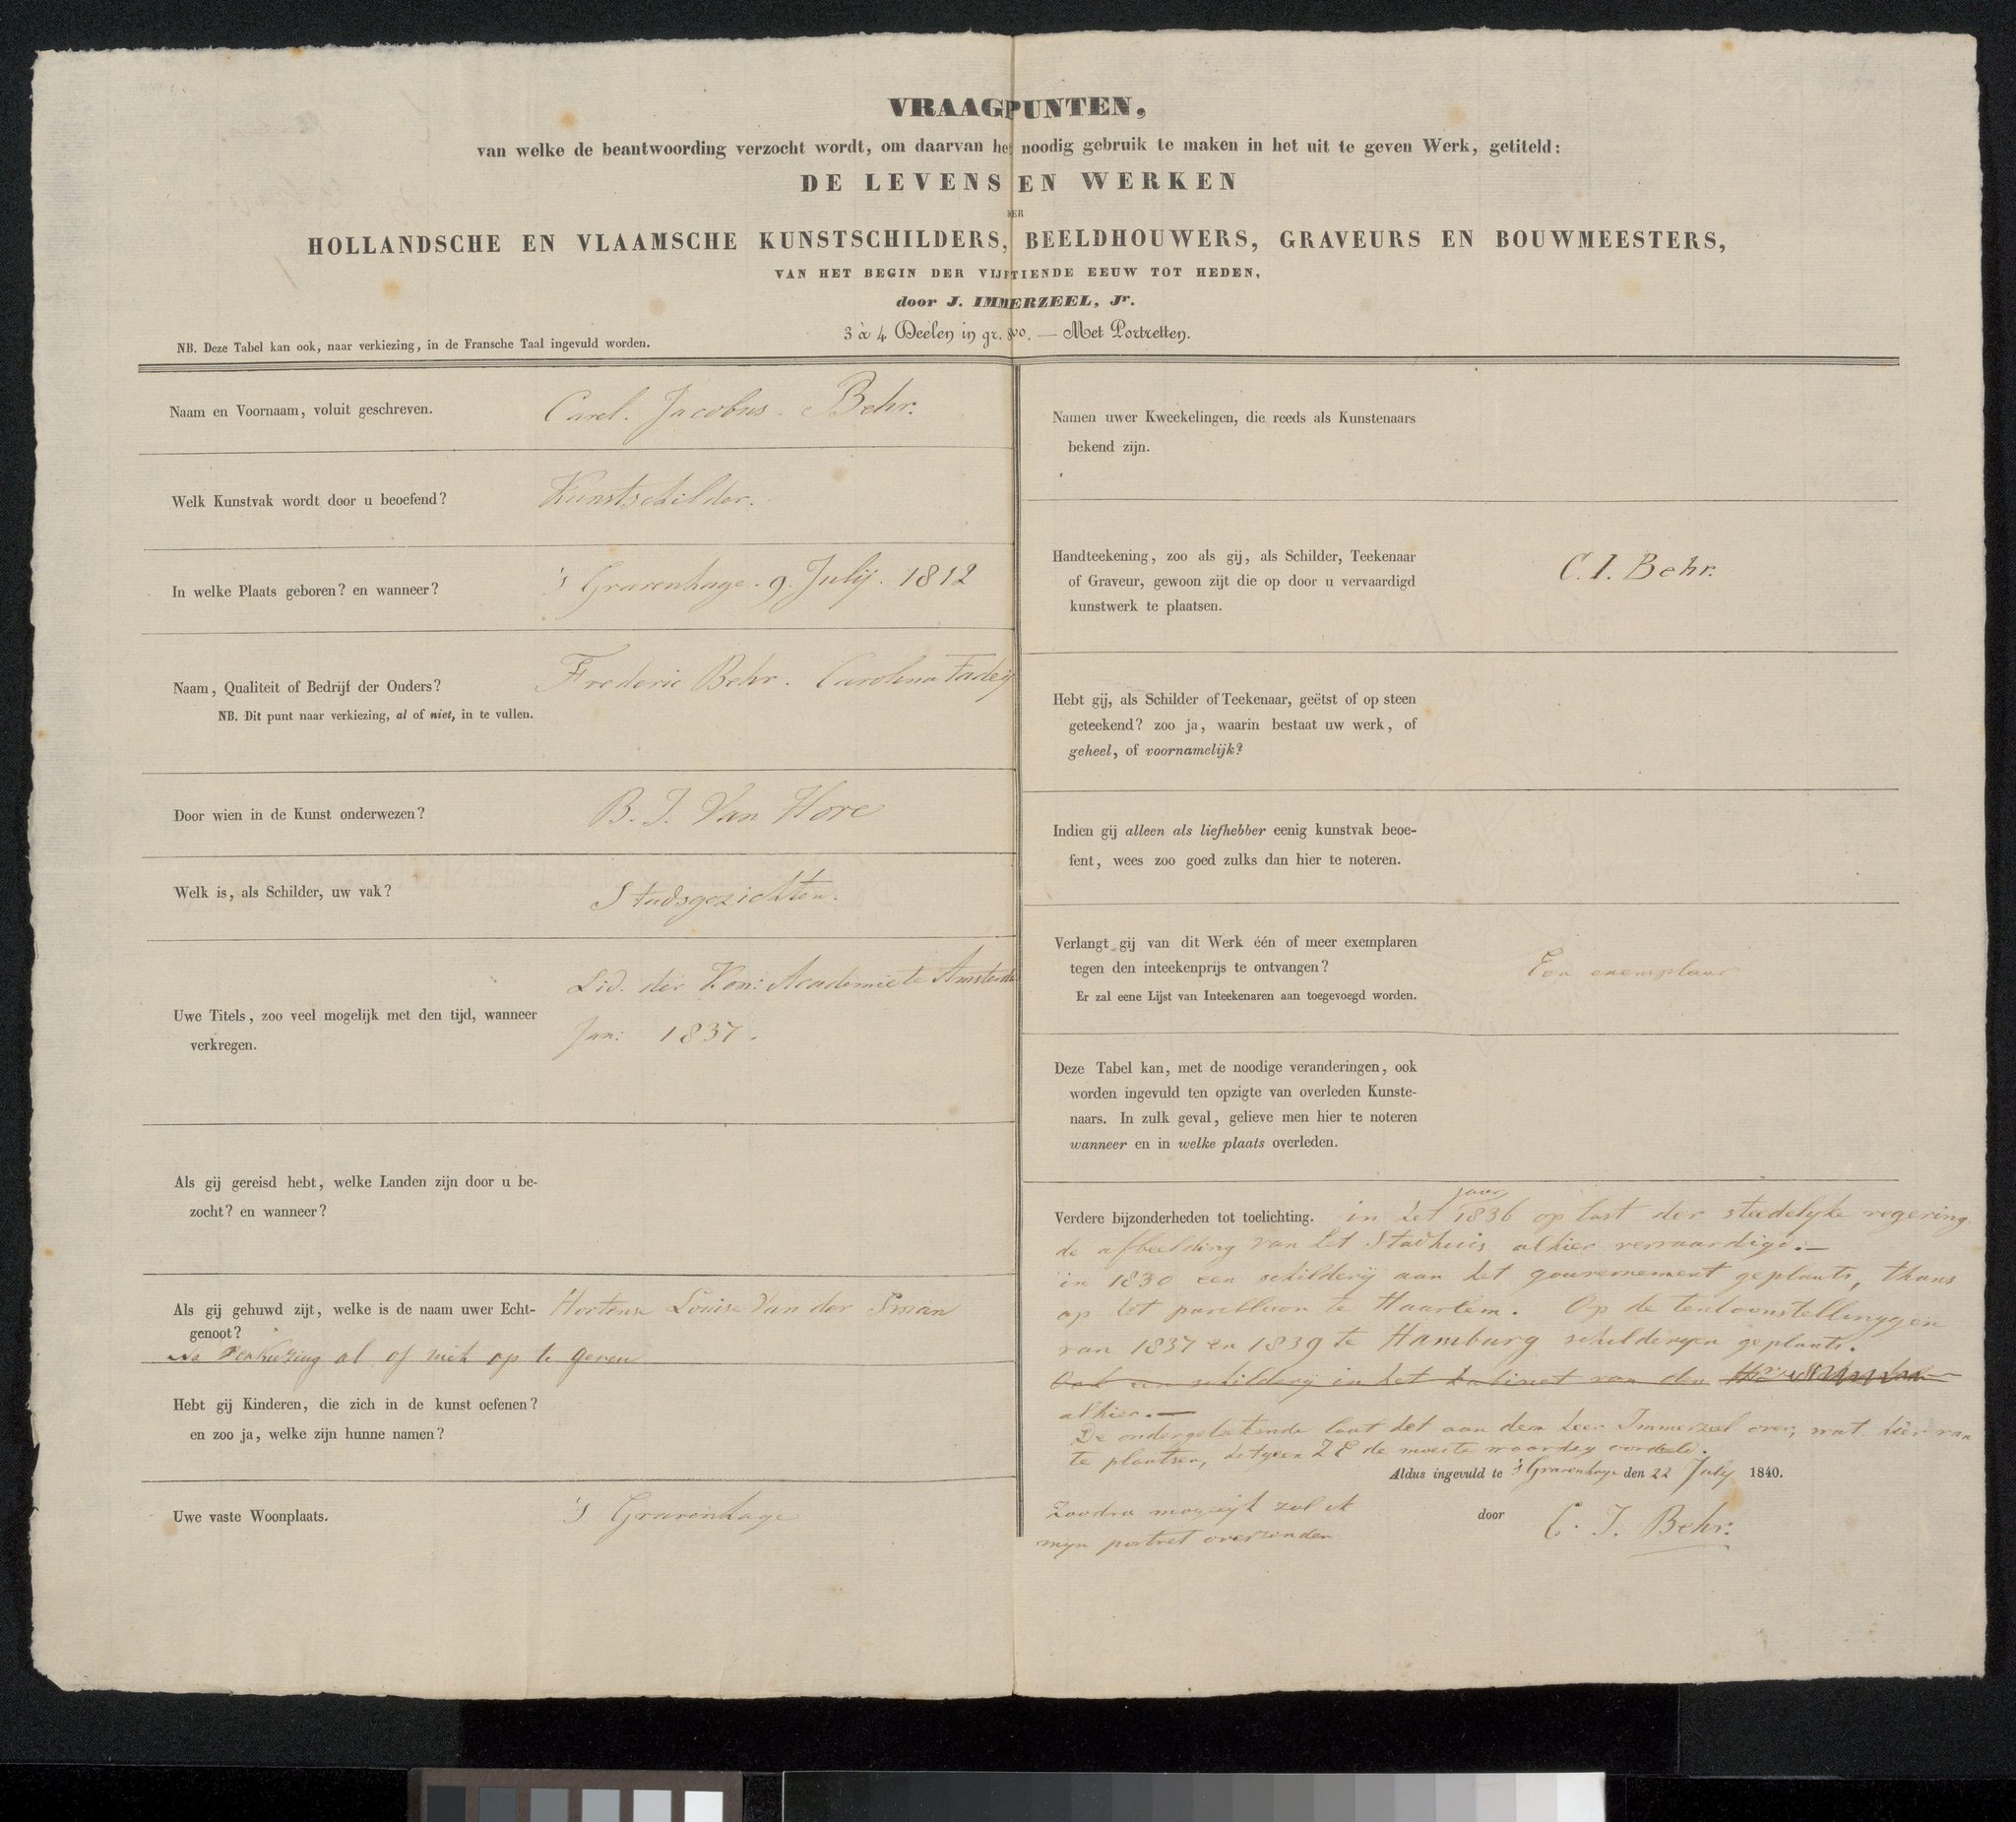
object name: questionnaire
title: Enquêteformulier ingevuld door Carel Jacobus Behr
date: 1840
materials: ink, paper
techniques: pen, printing, writing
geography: the hague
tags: draughtsman, carel jacobus behr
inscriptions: watermark, inscription: ‘Vraagpunten,/ van welke de beantwoording verzocht wordt, om daarvan het noodig gebruik te maken in het uit te geven Werk, getiteld: De levens en werken/ der Hollandsche en Vlaamsche kunstschilders, beeldhouwers,/ graveurs en bouwmeesters, van het begin der vijftiende eeuw tot heden/ door J. Immerzeel, Jr.’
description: Opgenomen in: Immerzeel, J. Jr., De levens en werken der Hollandsche en Vlaamsche kunstschilders, beeldhouwers, graveurs en bouwmeesters, van het begin der vijftiende eeuw tot heden, Amsterdam: J.C. van Kesteren, 1842-1843.